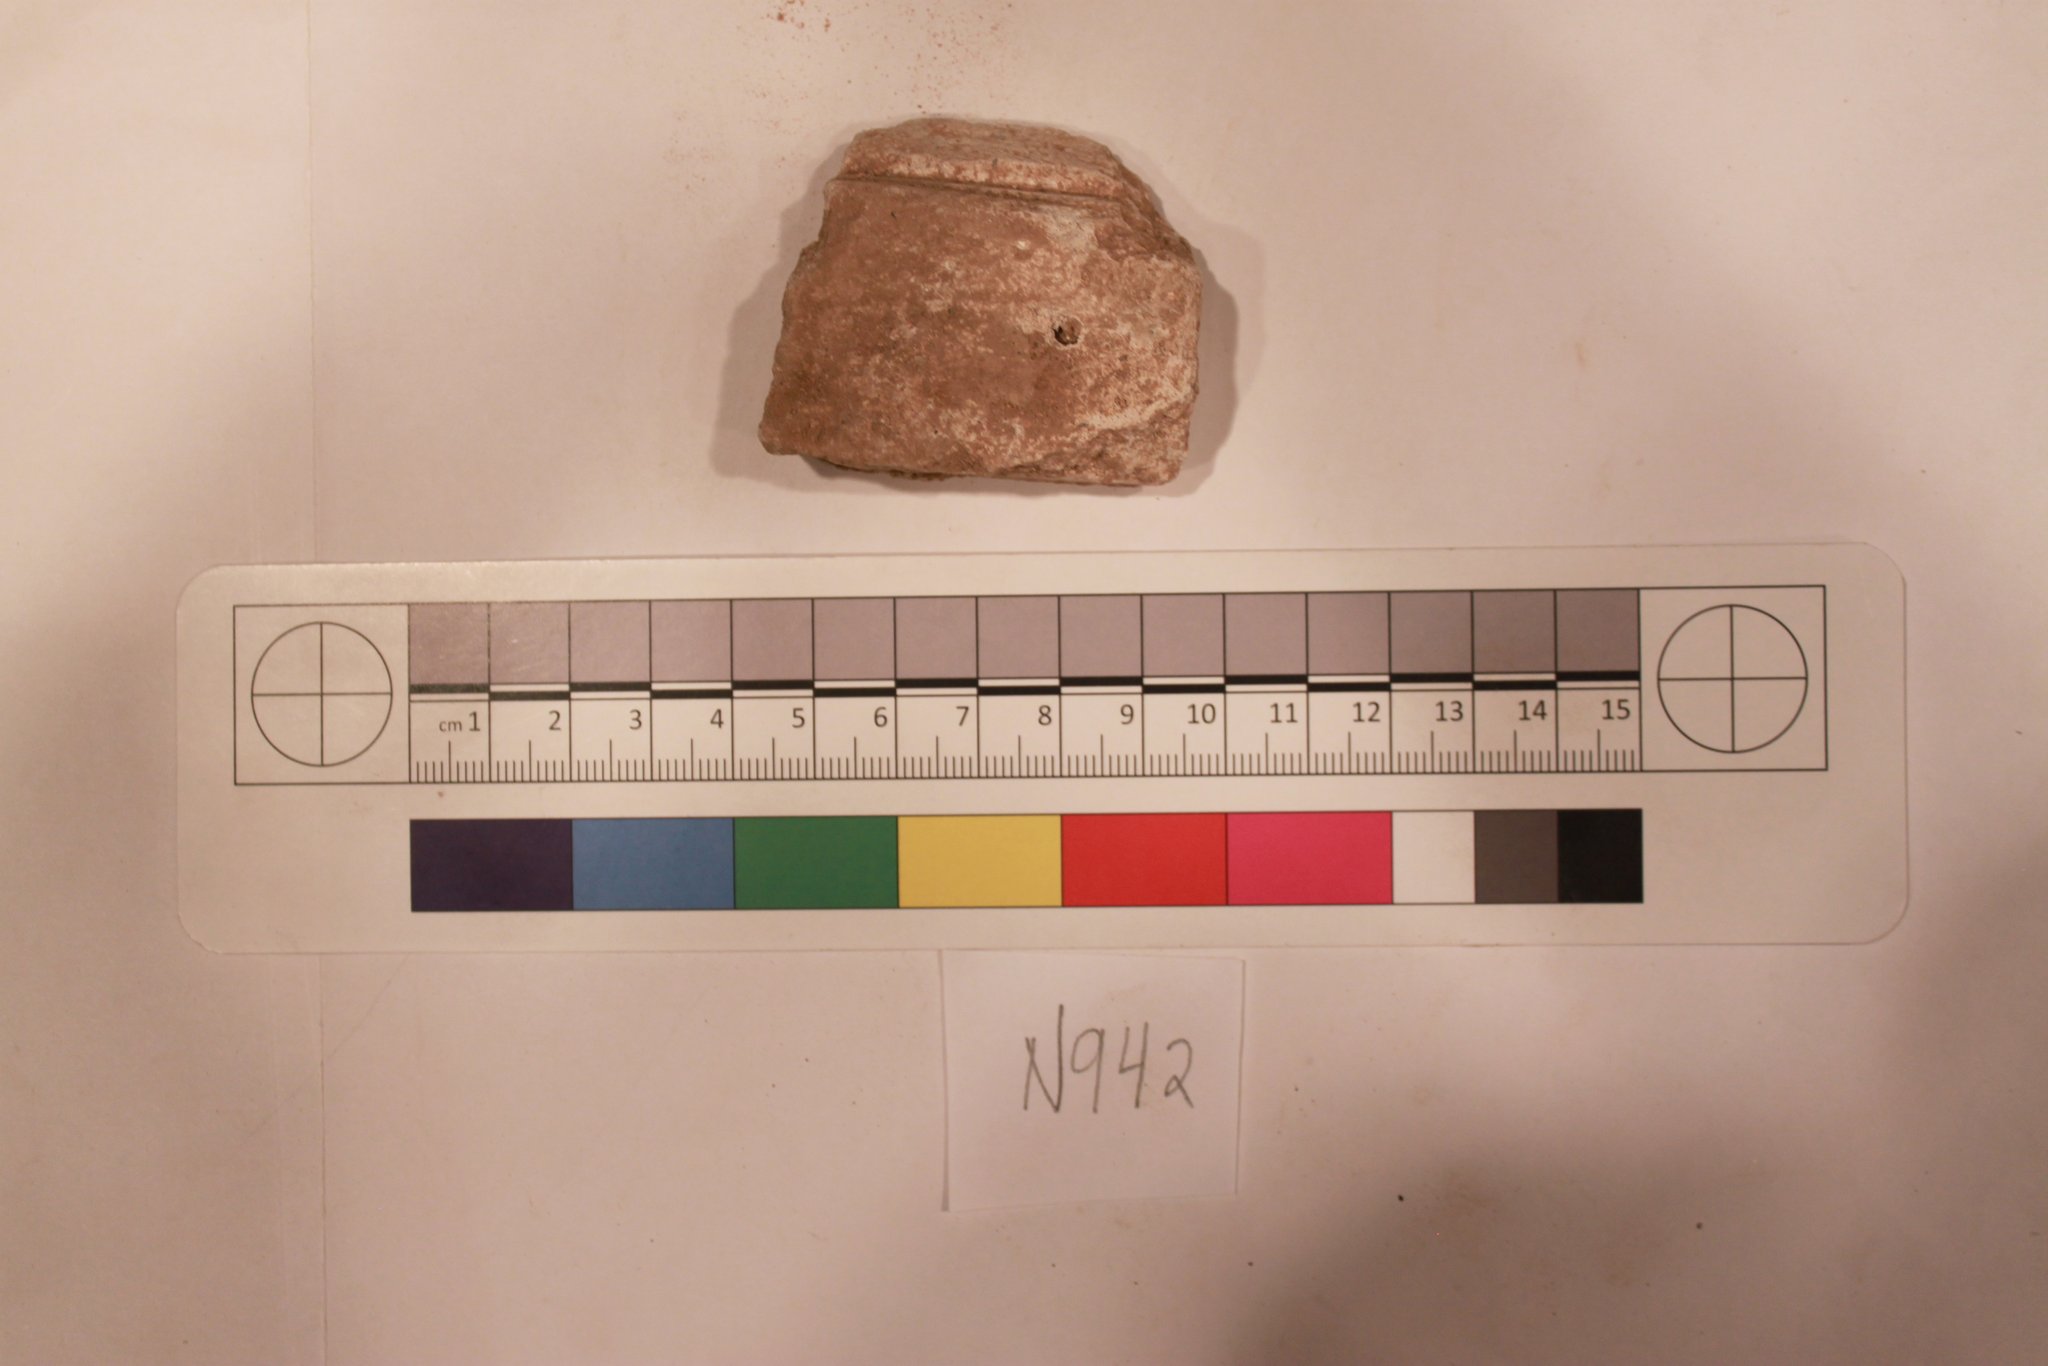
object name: fragment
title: Stucco Fragment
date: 701-1200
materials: plaster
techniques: carving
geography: iran